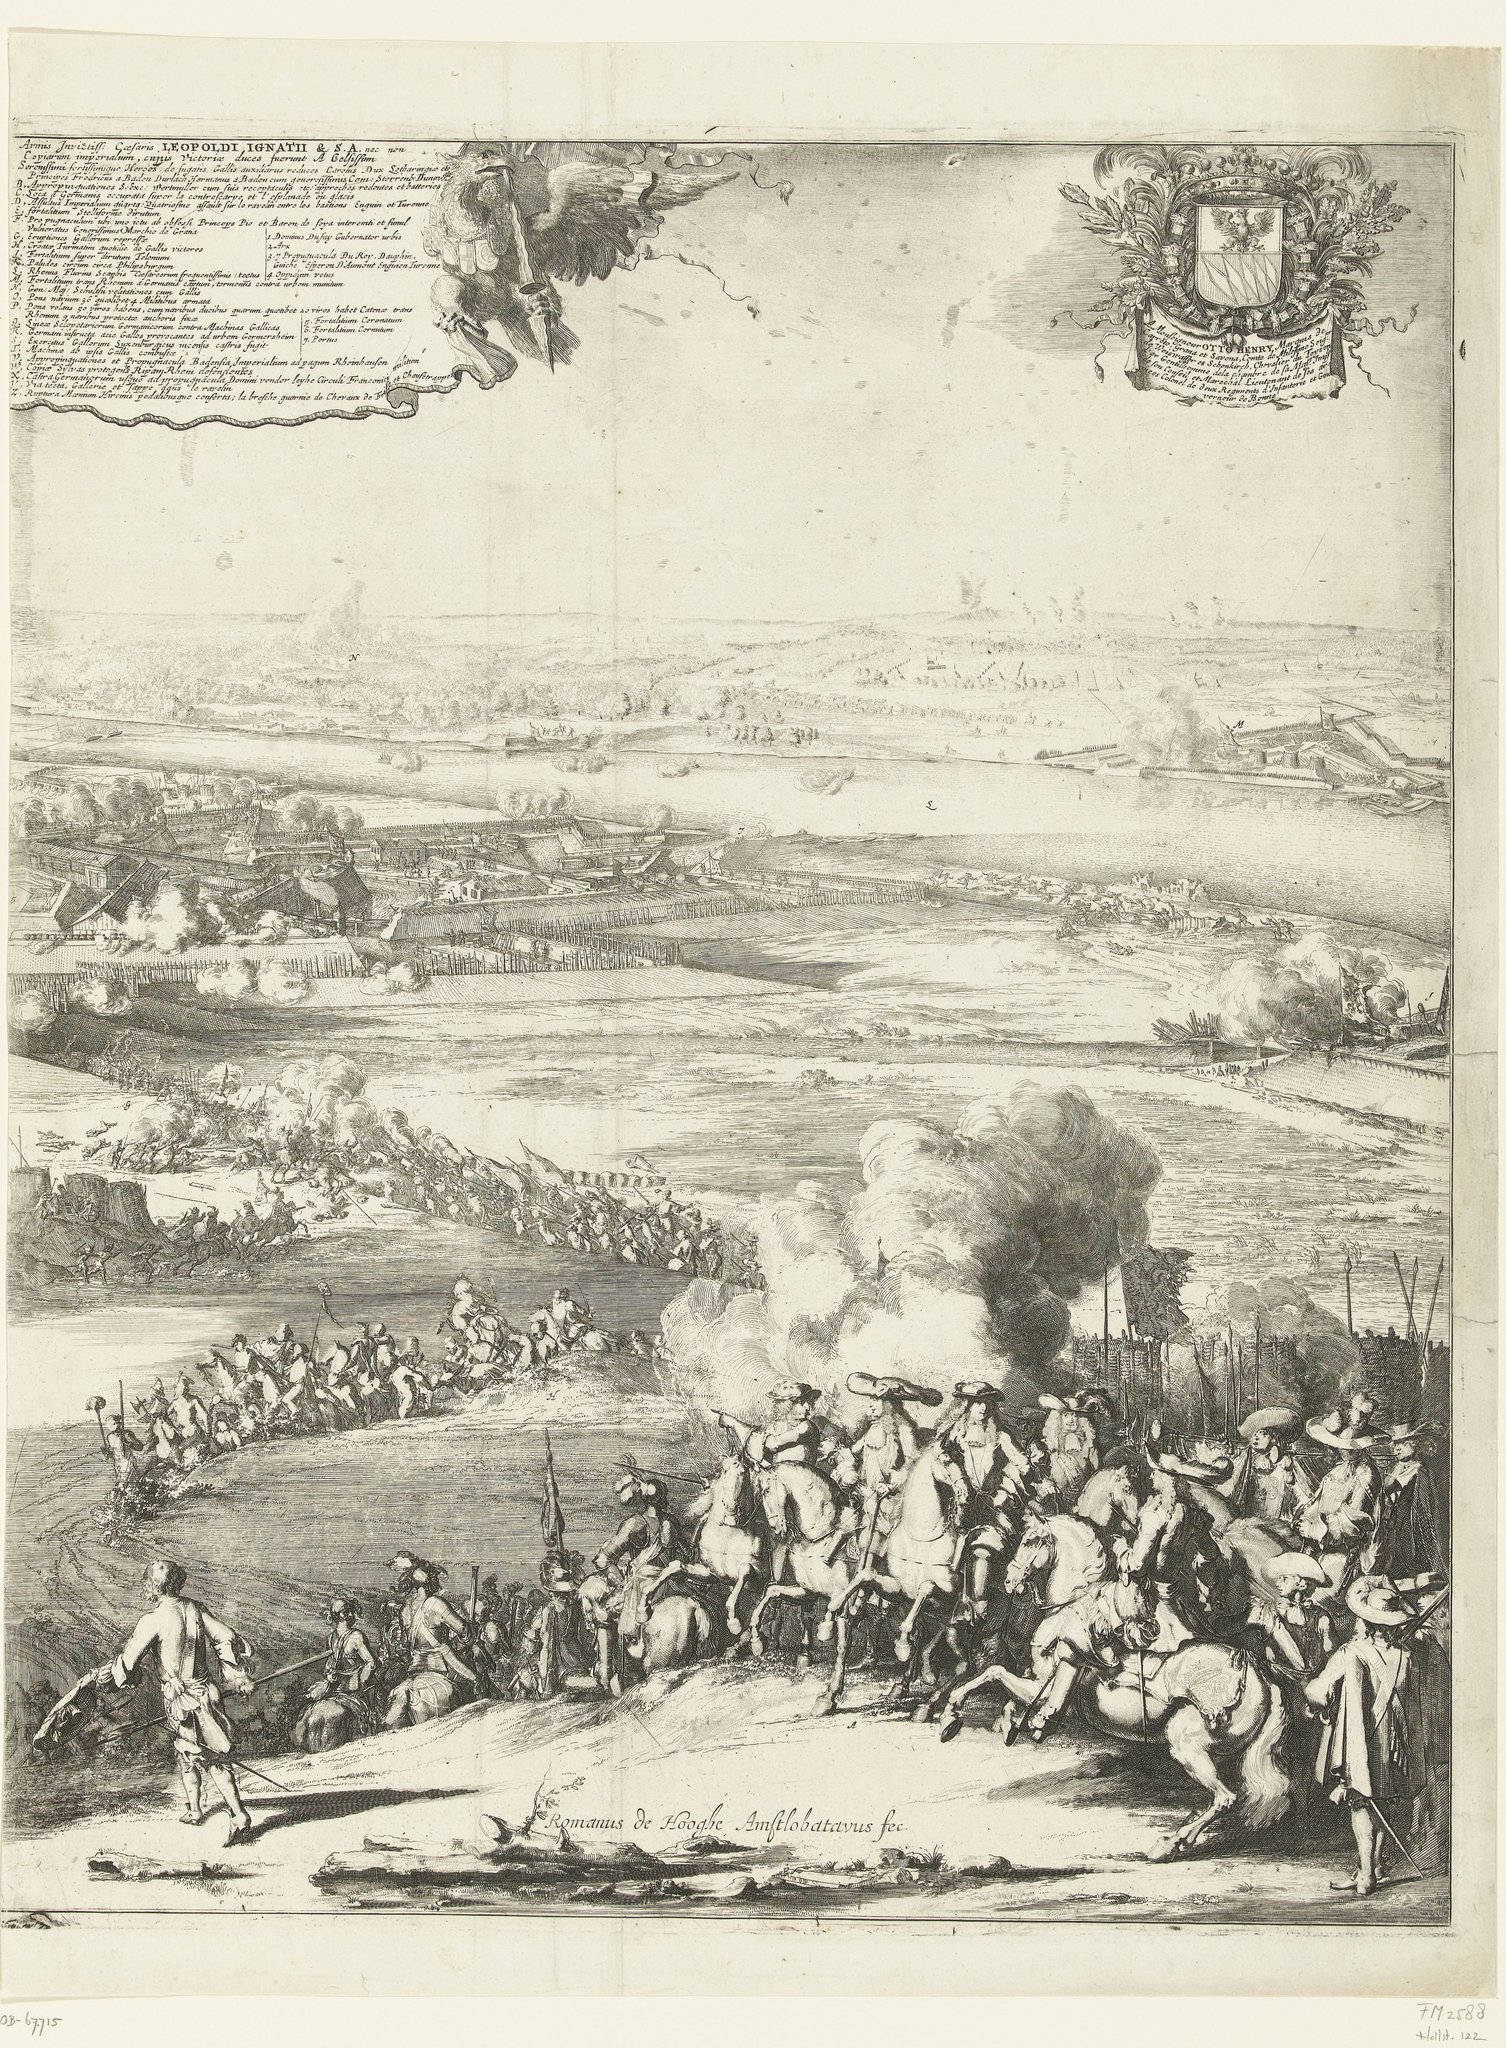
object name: print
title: Captum Philipsburgum Ao 1676 9/17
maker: romeyn de hooghe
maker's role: draughtsman, goldsmith, painter, print maker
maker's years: 1645-1708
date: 1676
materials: paper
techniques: etching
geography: amsterdam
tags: vienna, siege, position war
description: Rechterblad van een grote voorstelling van het beleg en de verovering van Philippsburg door de troepen van keizer Leopold I op 17 september 1676, op 2 bladen. Gezicht op het gebied rechts van de belegerde stad. Op de voorgrond de bevelhebbers, Karel van Lotharingen en Hendrik van Baden-Durlach. Rechtsboven een doek met een Franse tekst, linksboven de rechterhelft van een groter tekst met de legenda A-Z in het Latijn op een doek.